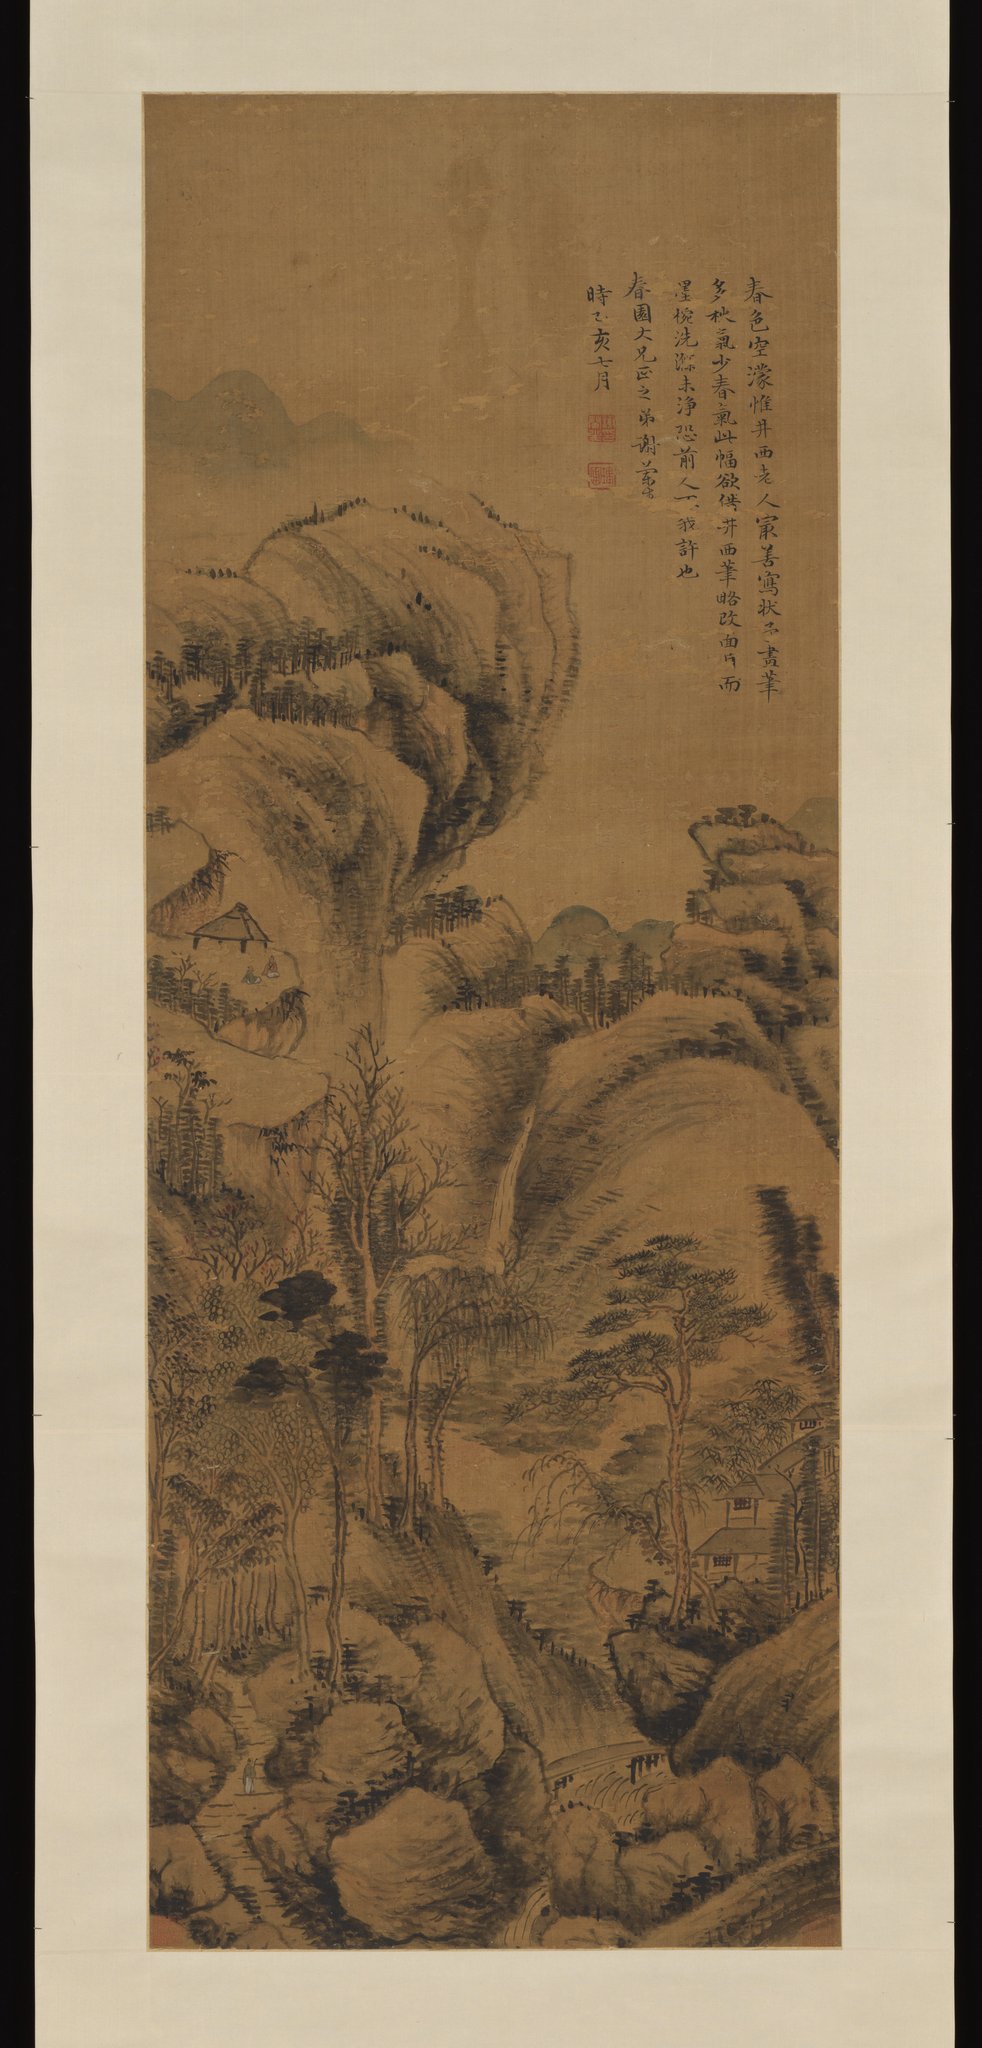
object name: hanging scroll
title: Landscape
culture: chinese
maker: xie lansheng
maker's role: artist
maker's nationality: chinese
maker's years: 1760-1831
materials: ink, silk